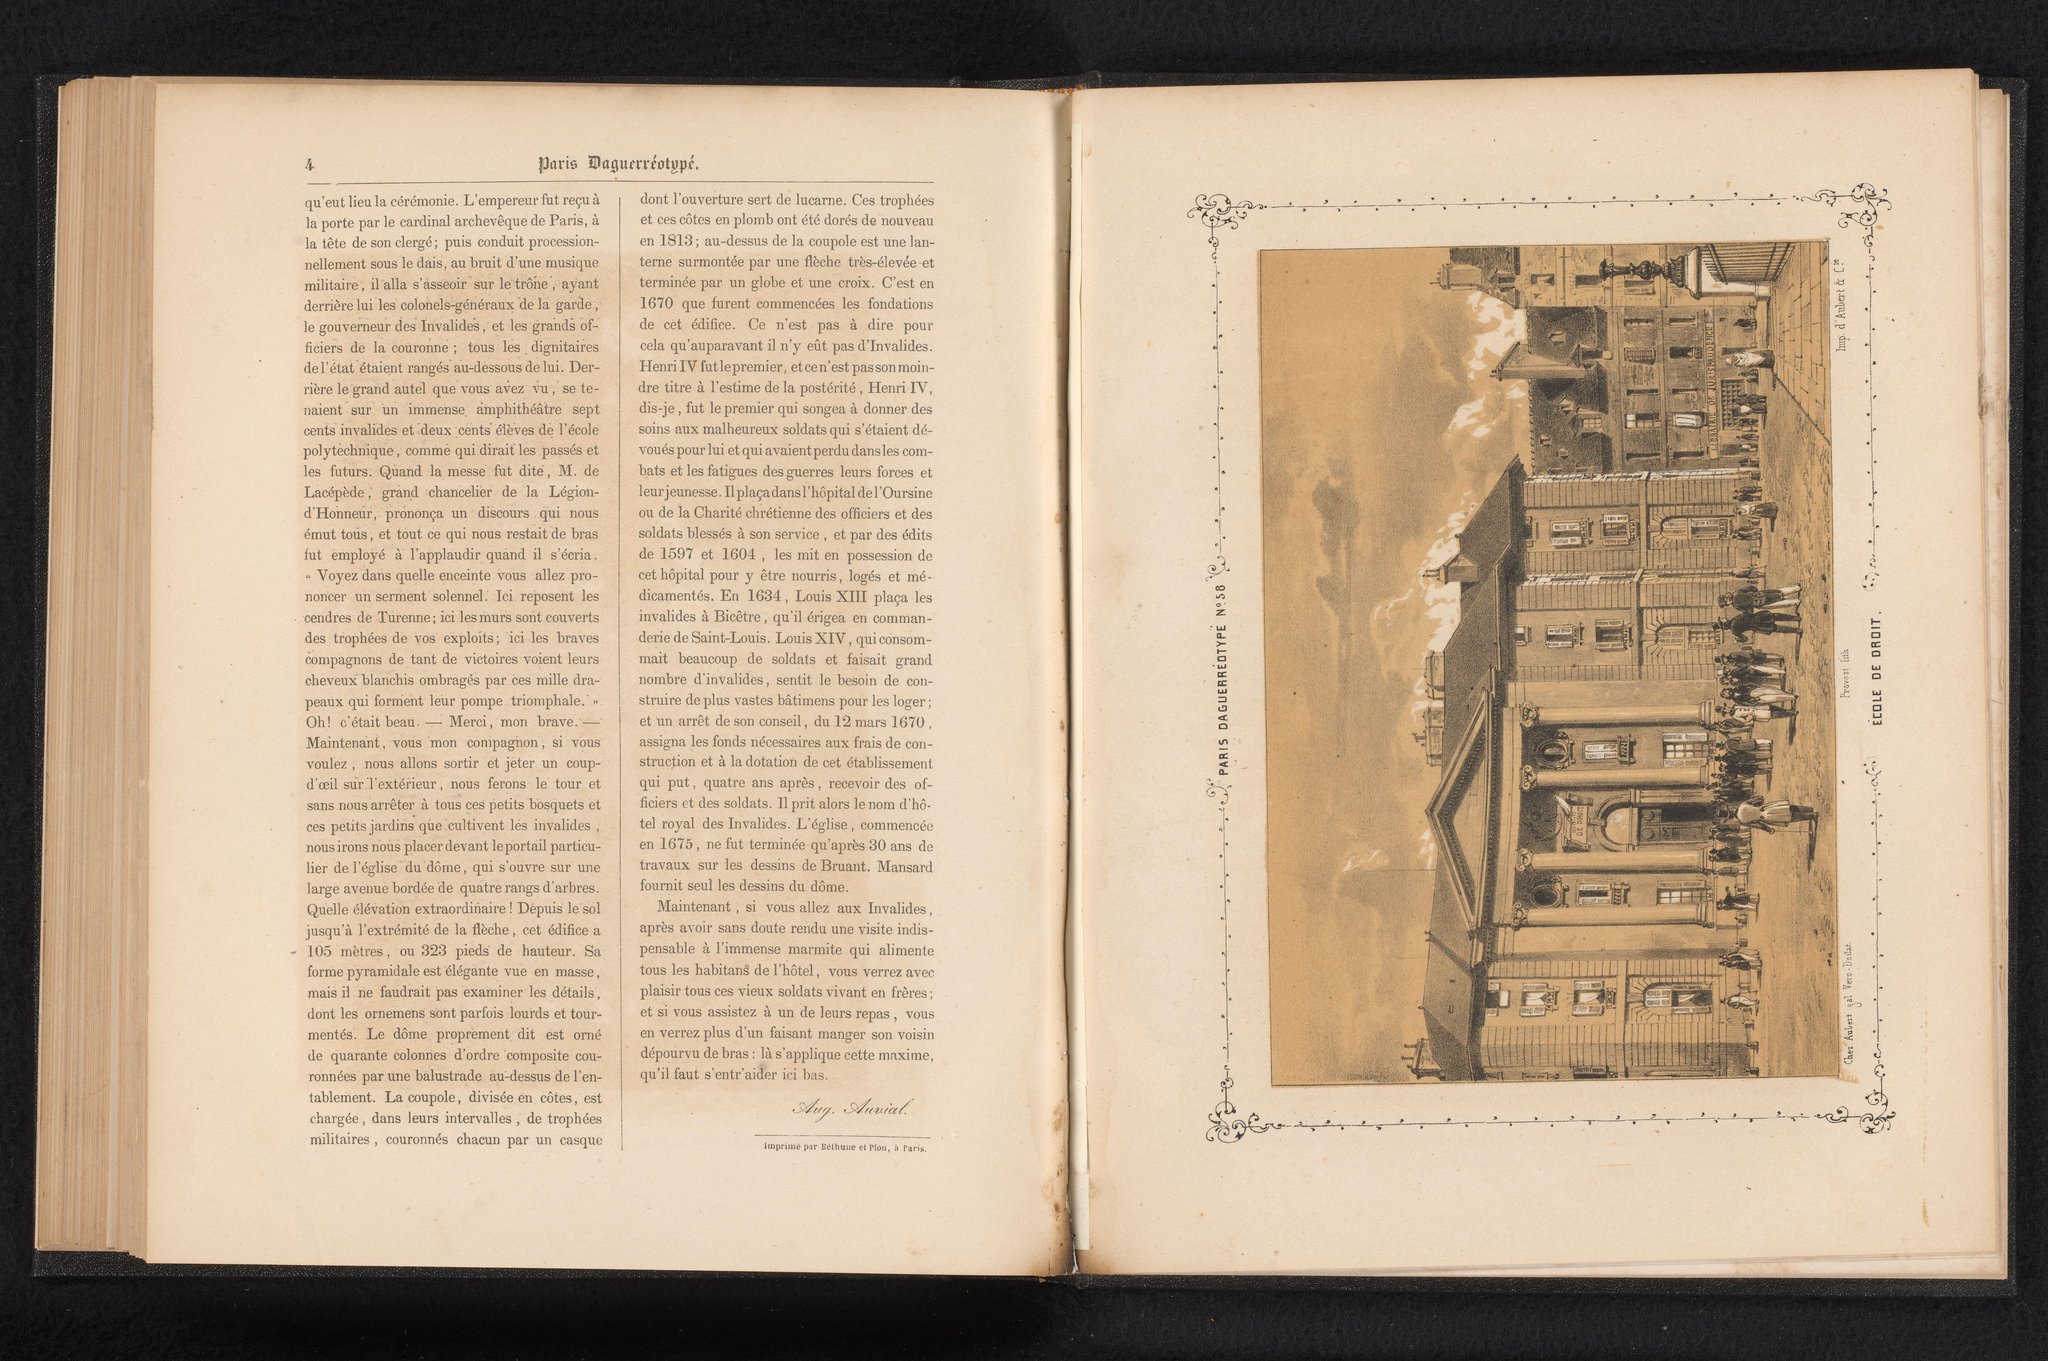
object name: page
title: Faculteit der Rechtsgeleerdheid van de Sorbonne in Parijs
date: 1839-1840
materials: paper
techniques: tone lithography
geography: paris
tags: faculties ~ university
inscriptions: inscription: ‘PARIS DAGUERRÉOTYPÉ No. 58.’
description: Prent op tweehonderdeenendertigste ongenummerde pagina.